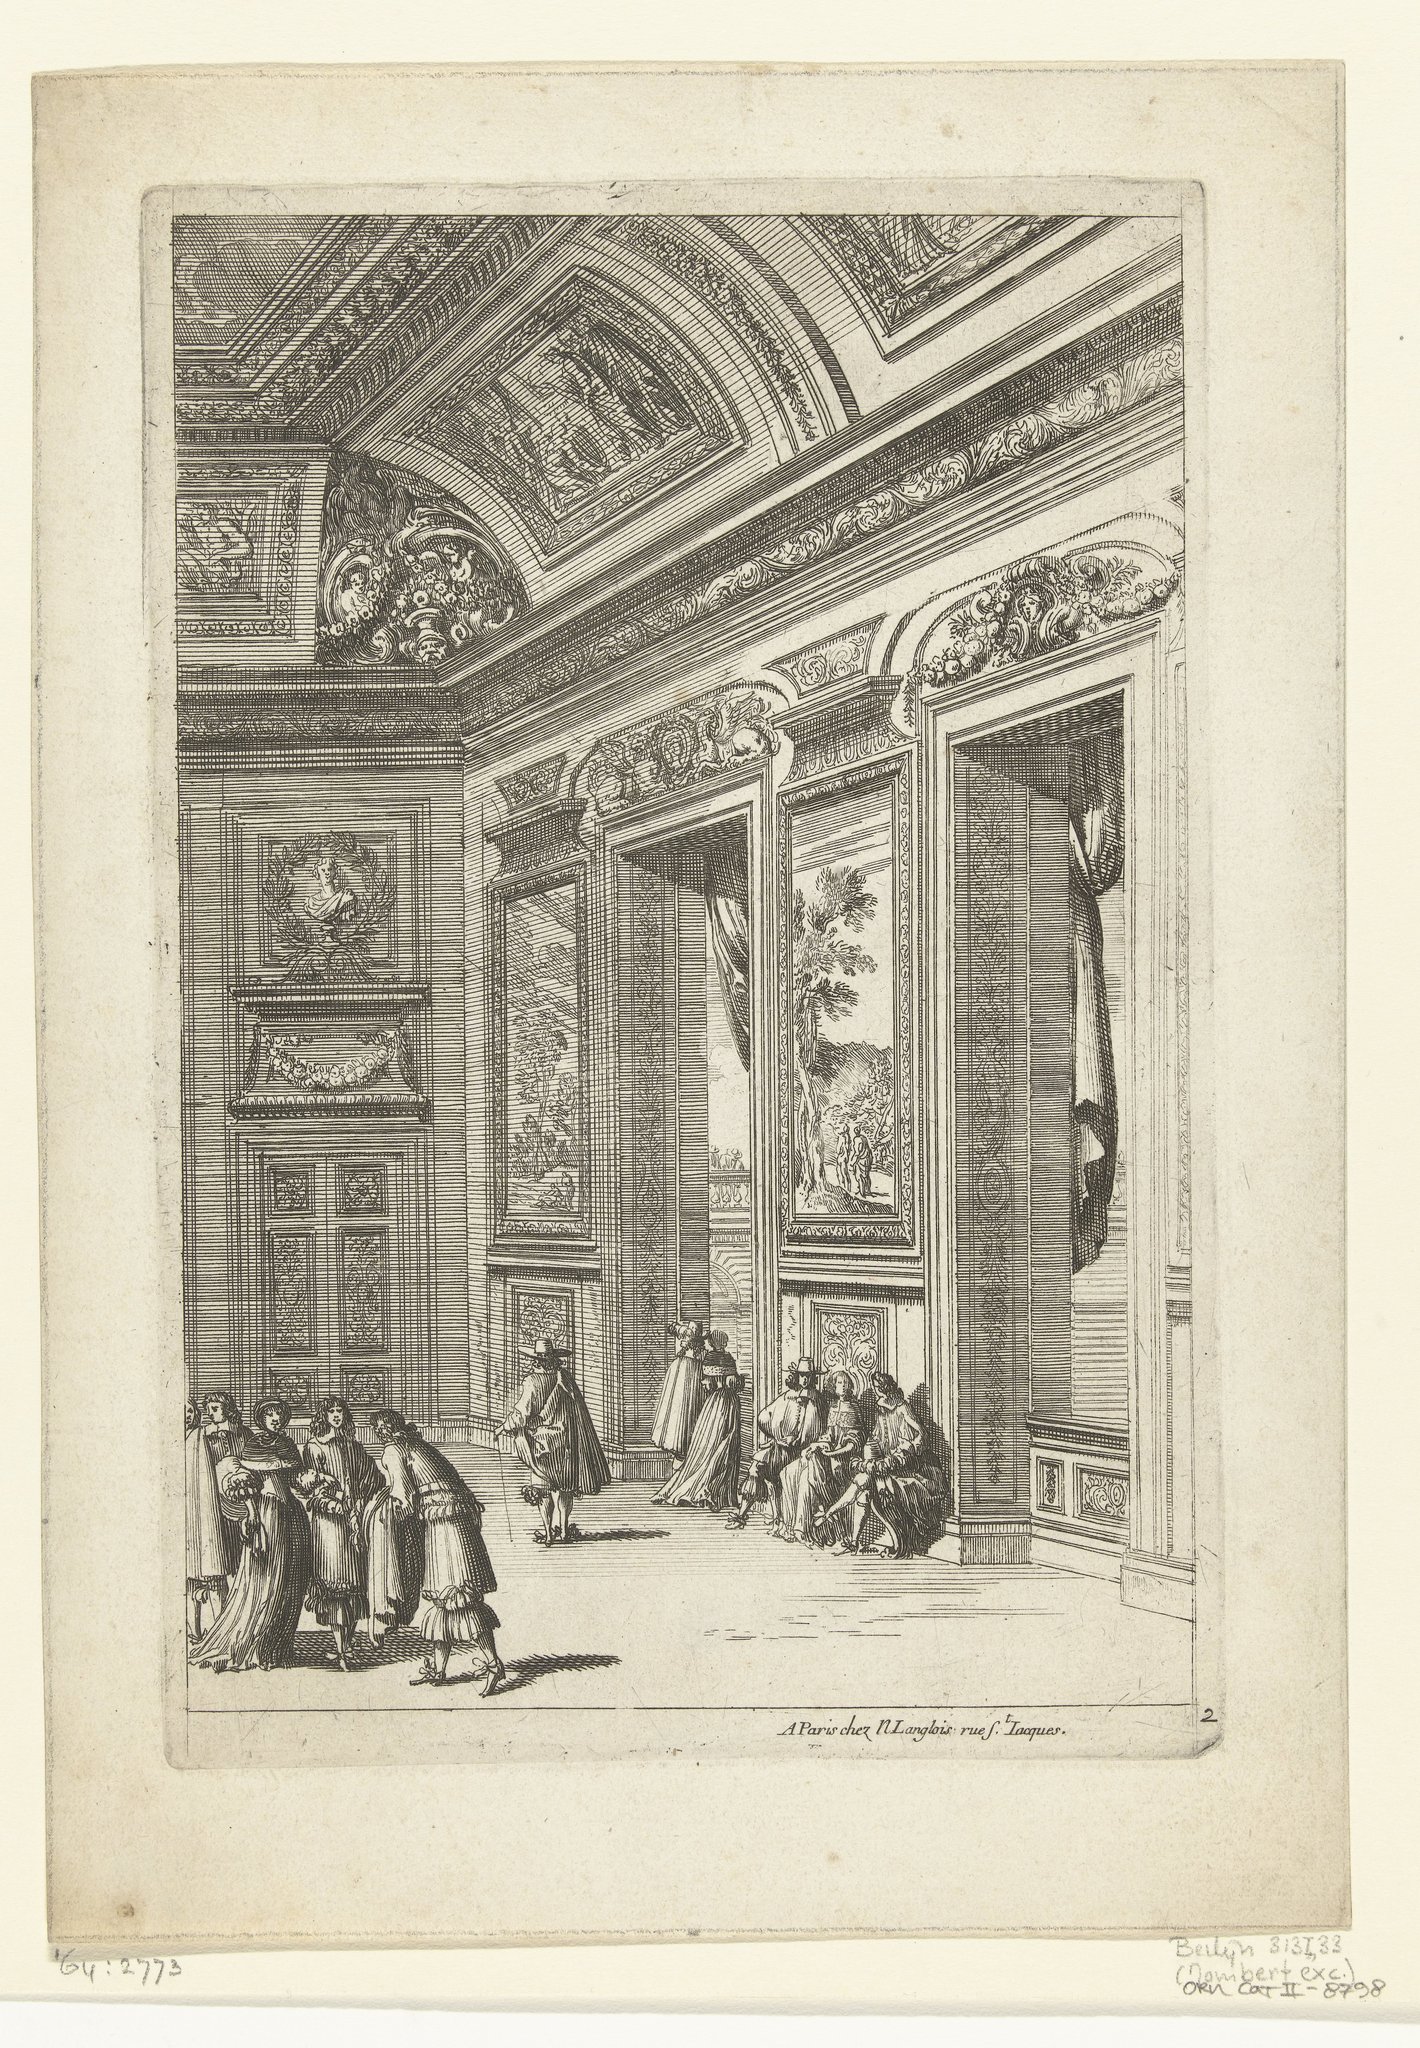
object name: ornament print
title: Desseins De lambris à l'Italienne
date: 1670-1680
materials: paper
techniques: etching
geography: france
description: Met verschillende figuren gekleed in de laatste mode. Uit serie bladen met houten lambrisering, op Italiaanse wijze uitgevoerd. Derde editie.